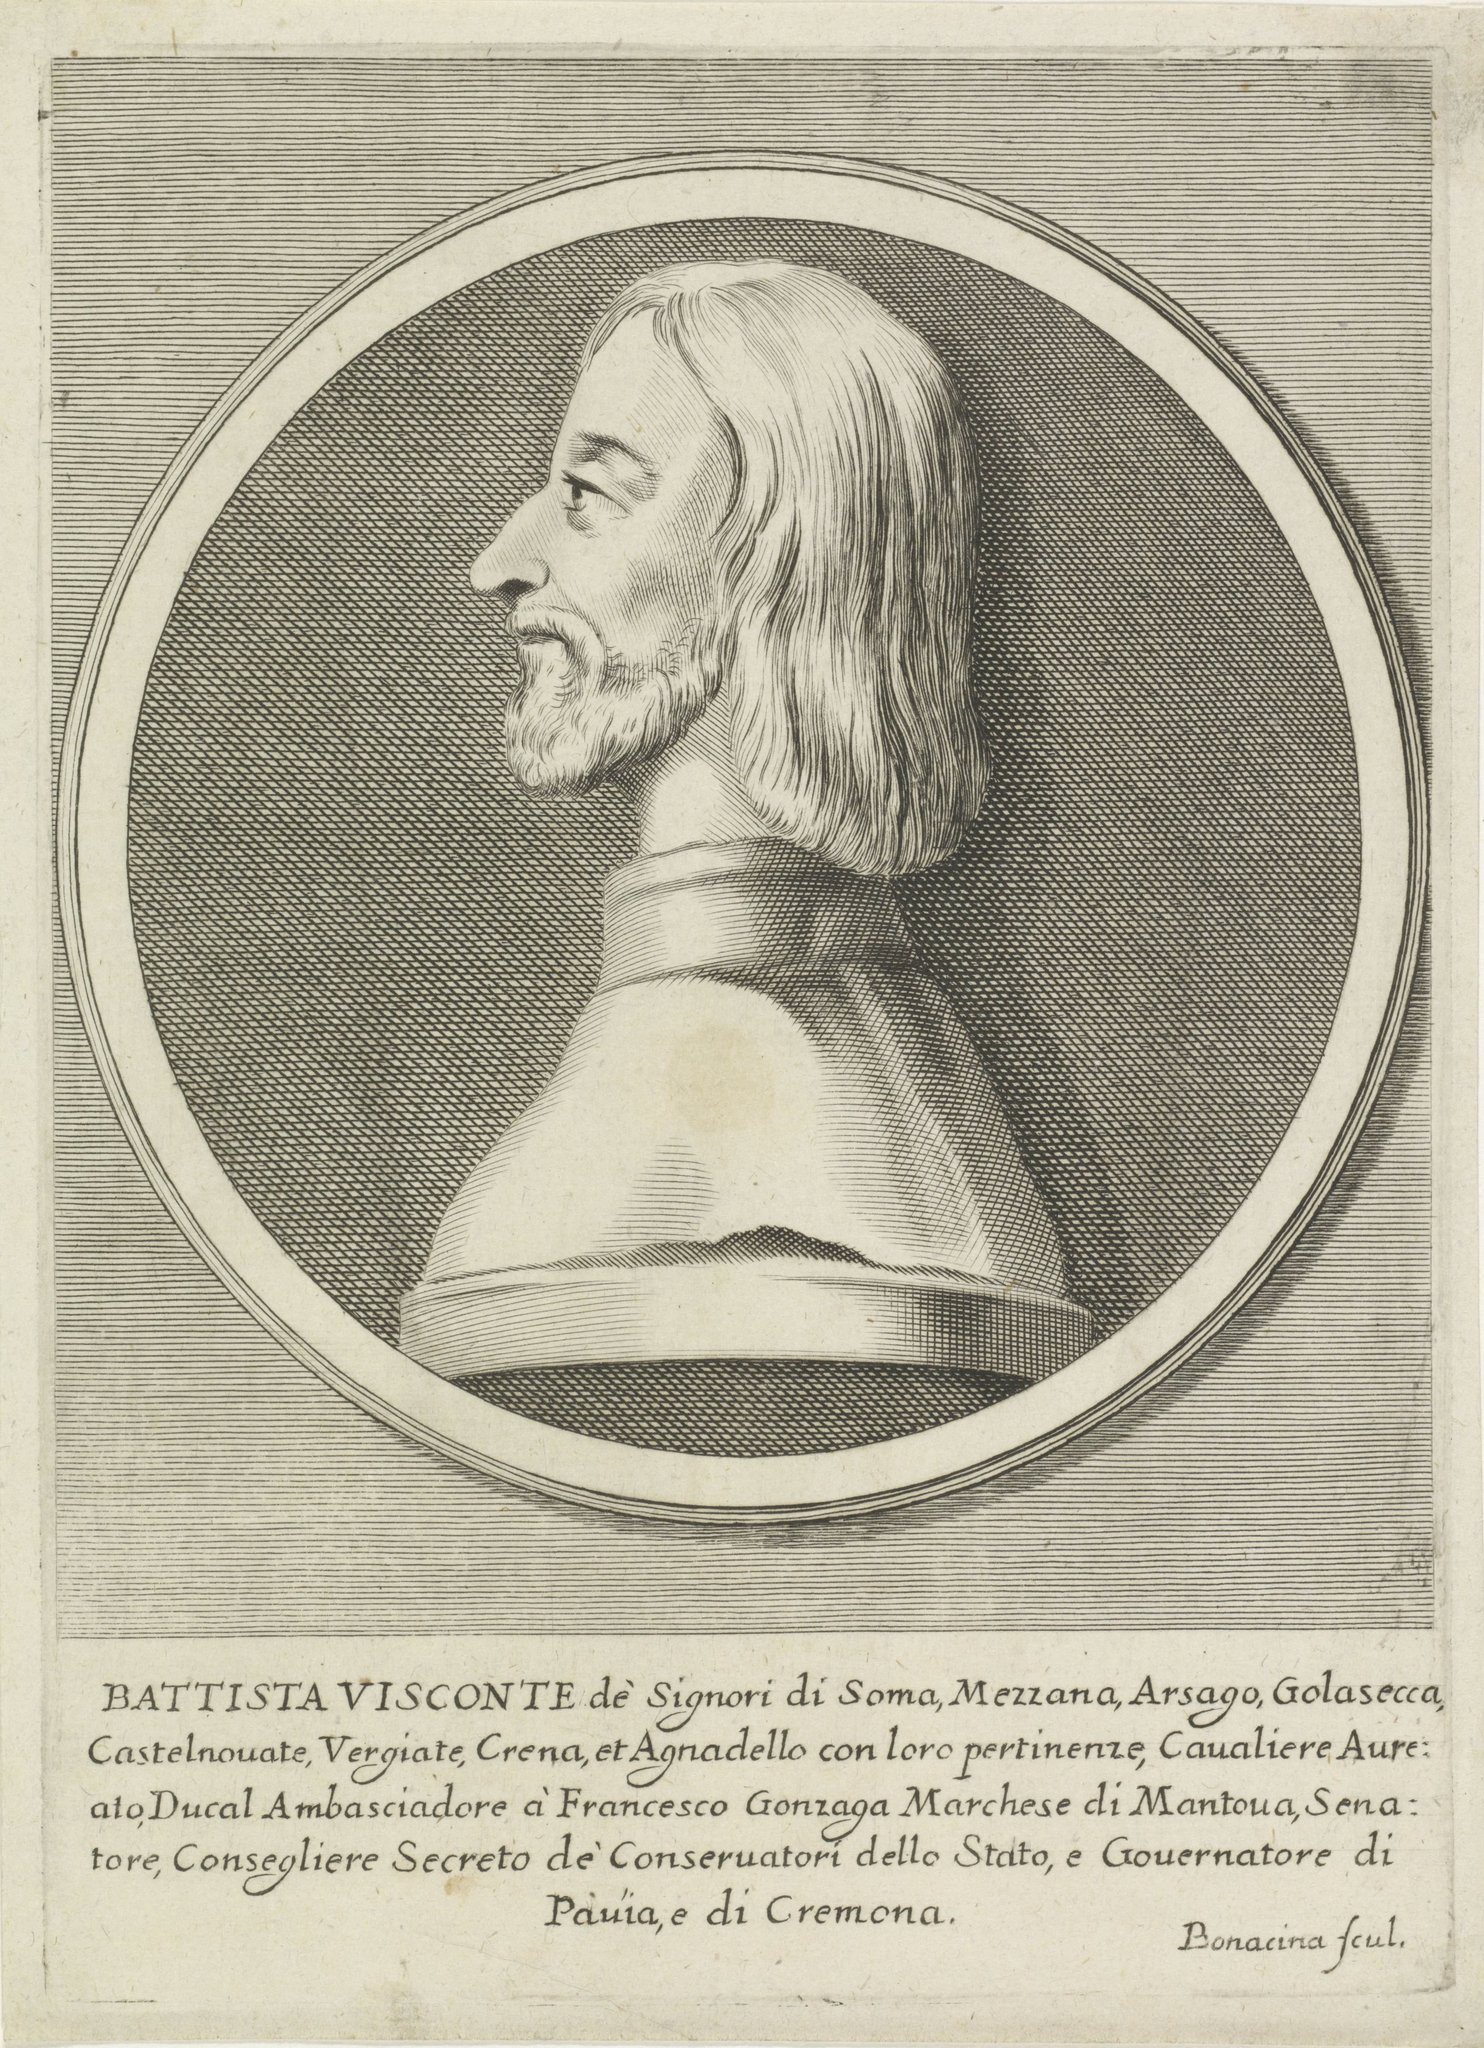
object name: print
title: Portret van Battista Visconti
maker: giovanni battista bonacina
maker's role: print maker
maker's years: 1615-1669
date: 1625-1669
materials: paper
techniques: engraving, etching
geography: italy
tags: historical persons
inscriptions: collector's mark: Lugt 2228